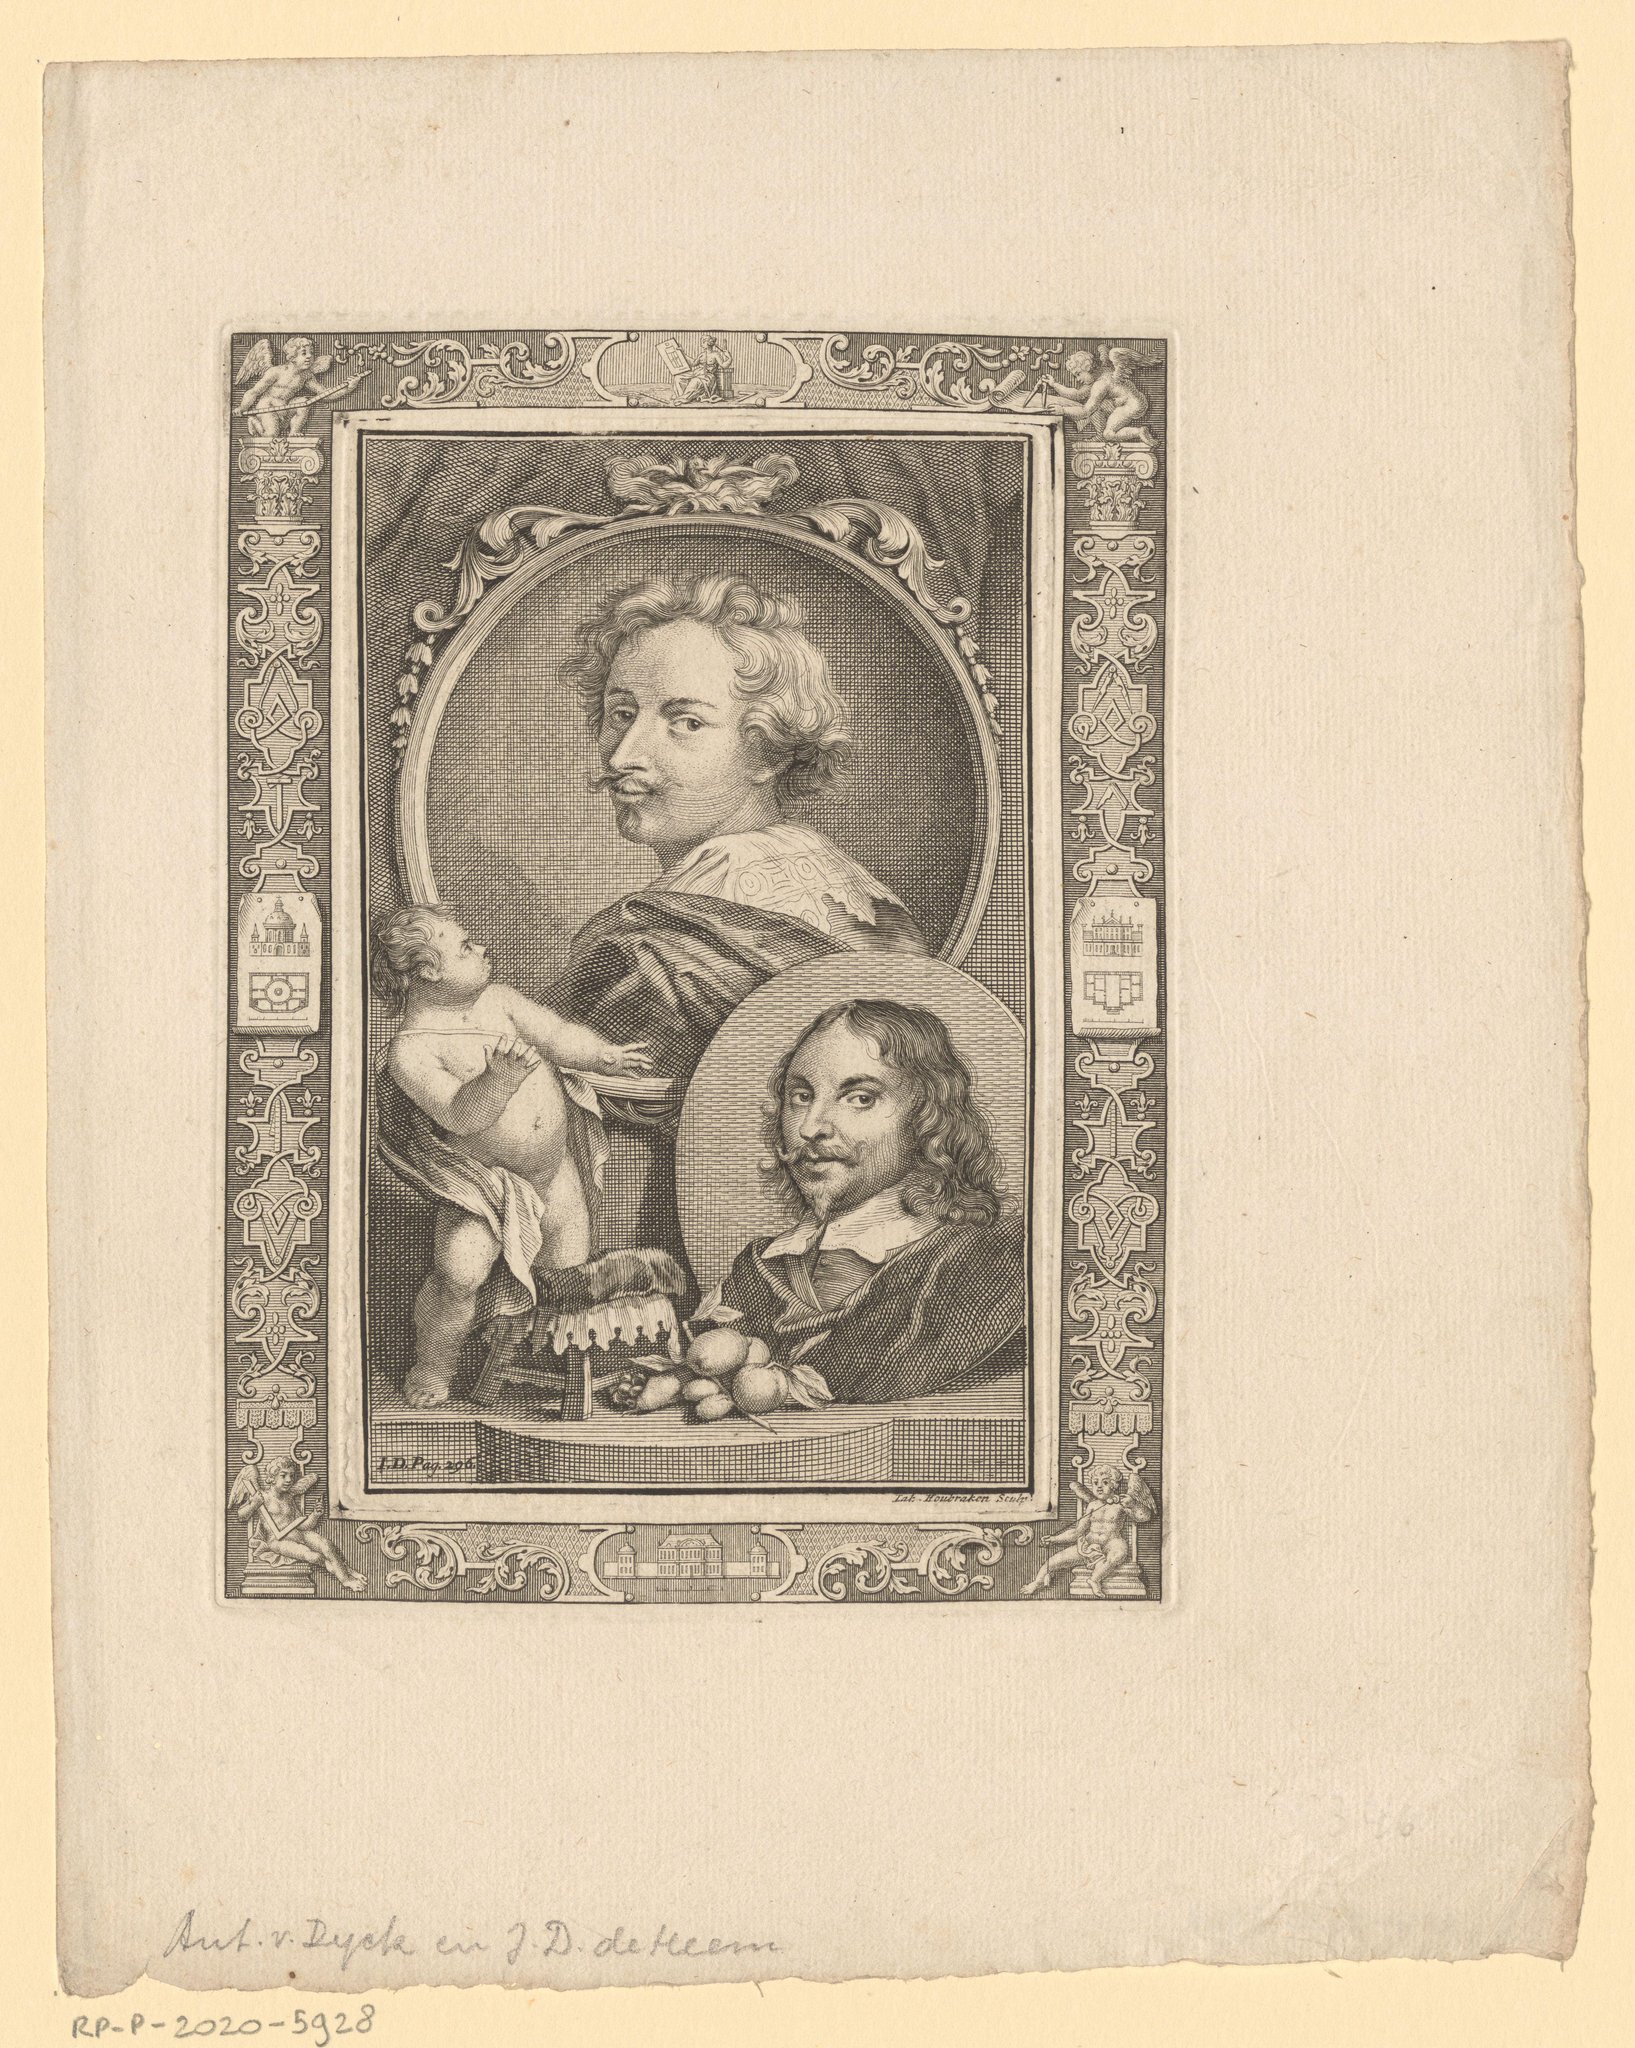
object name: print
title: Portret van Anthony van Dyck en portret van Jan Davidsz. de Heem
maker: jacob houbraken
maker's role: draughtsman, print maker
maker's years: 1698-1780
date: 1729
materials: paper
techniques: engraving, etching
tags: utrecht, jan davidsz. de heem, antwerp, london, painter, print maker, draughtsman, anthony van dyck, flowers, historical persons, fruits, cupids: 'amores', 'amoretti', 'putti'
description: Prent mogelijk uit: Weyerman, Jacob Campo. De levens-beschryvingen der Nederlandsche konst-schilders en konst-schilderessen (...). 4 dln. Den Haag: weduwe Engelbrecht Boucquet, Hendrik Scheurleer, Frederik Bouquet en Jan de Jongh, 1729, dl. 1. Eerdere staat van prent gebruikt in: Houbraken, Arnold. De groote schouburgh der Nederlantsche konstschilders en schilderessen (...). Amsterdam: Arnold Houbraken, 1718, dl. 1.